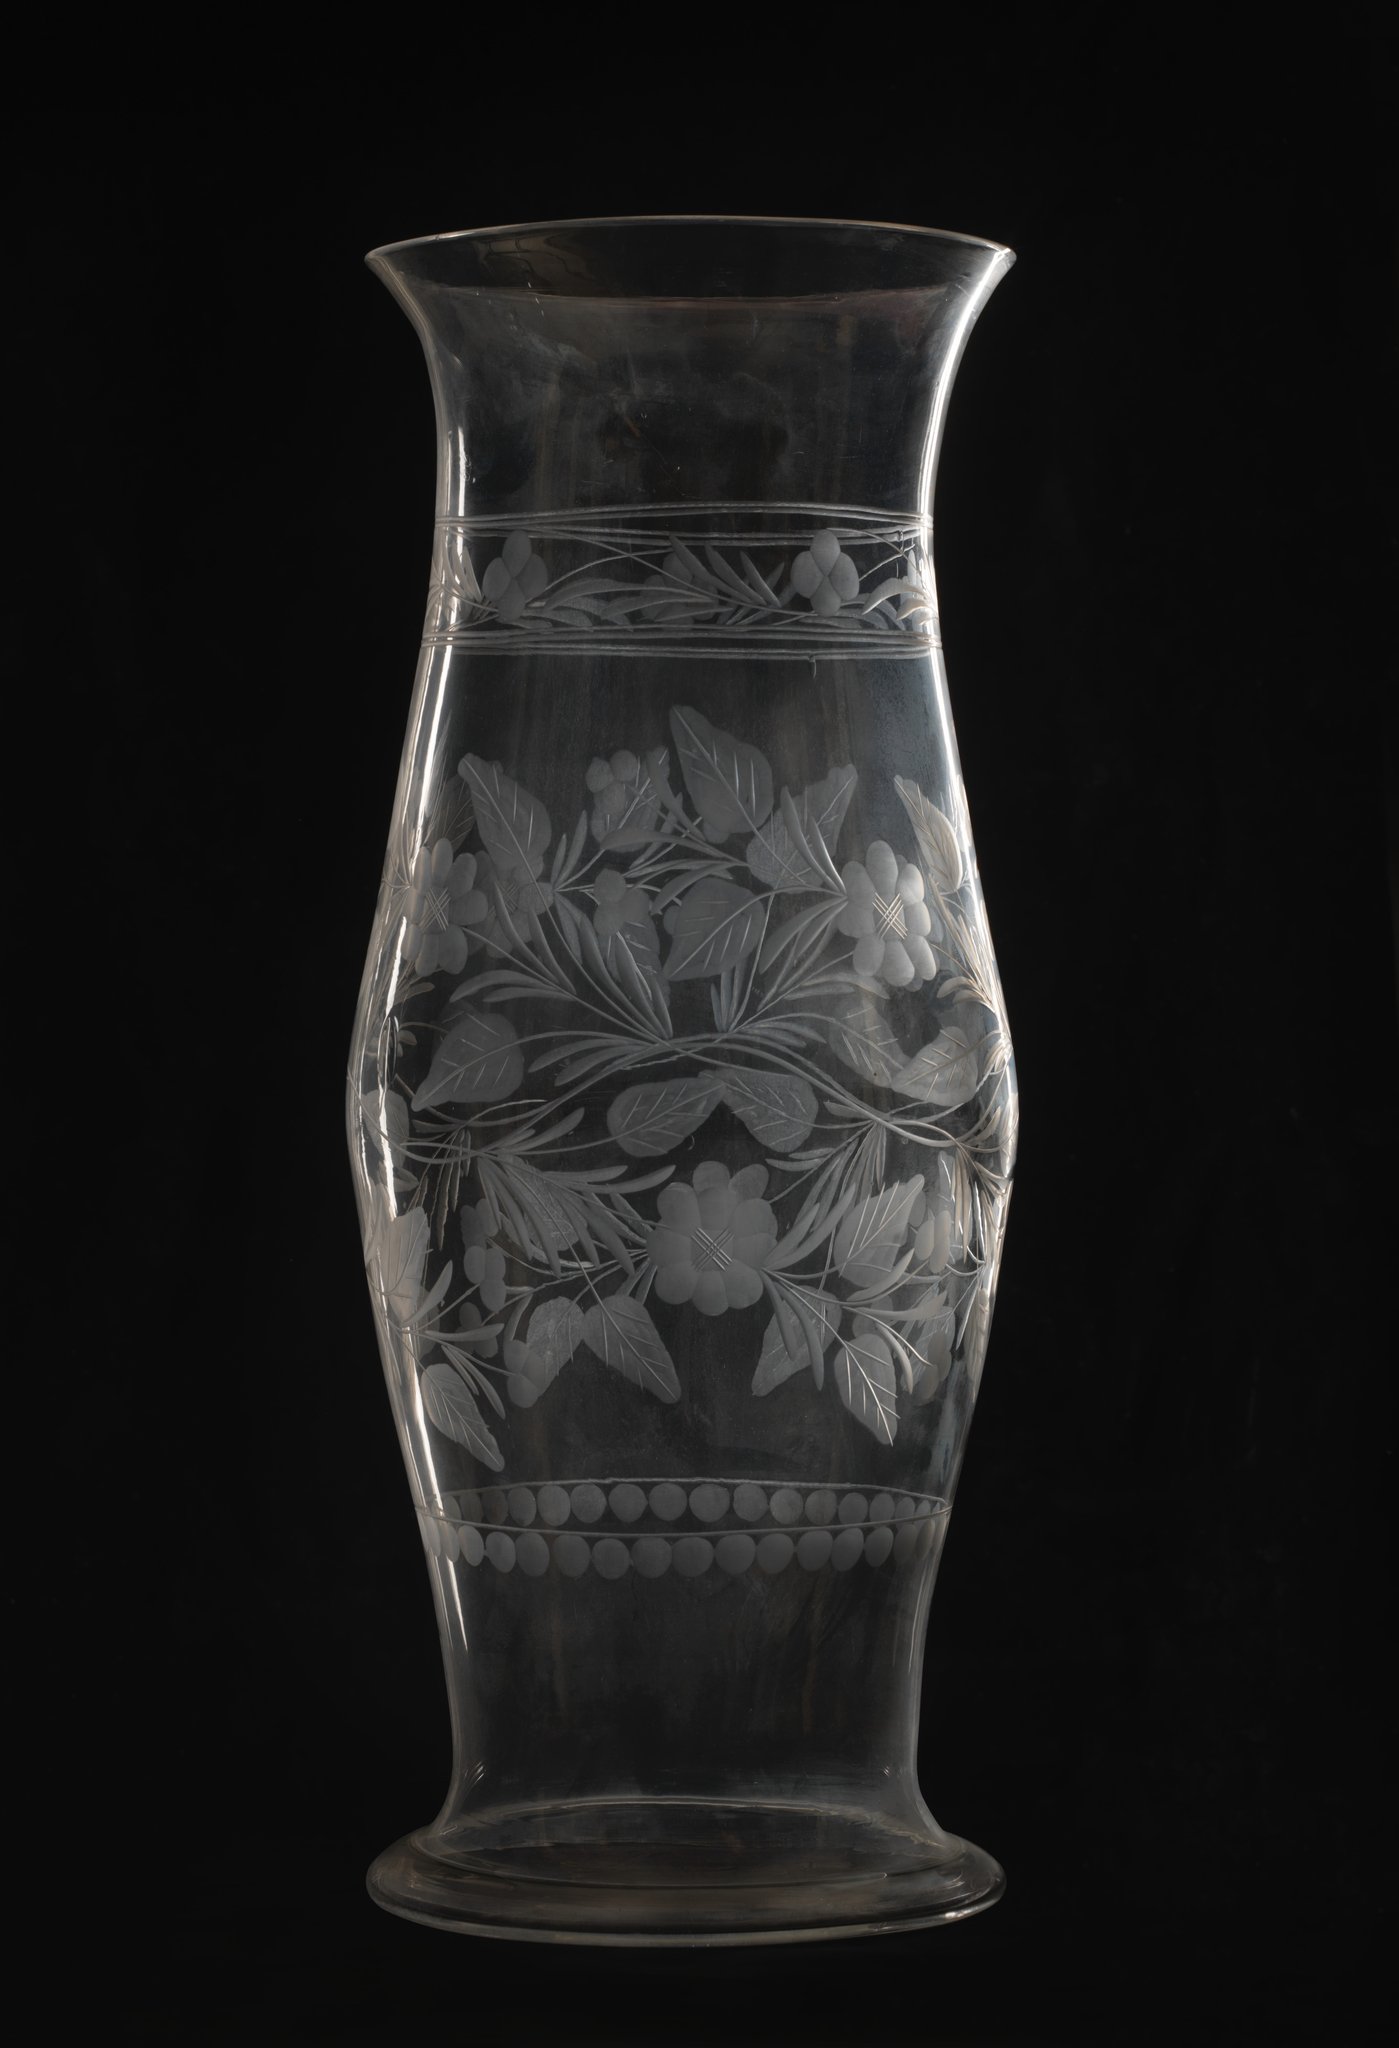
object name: hurricane glass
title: Hurricane glass (one of a pair)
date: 1801-1833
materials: glass